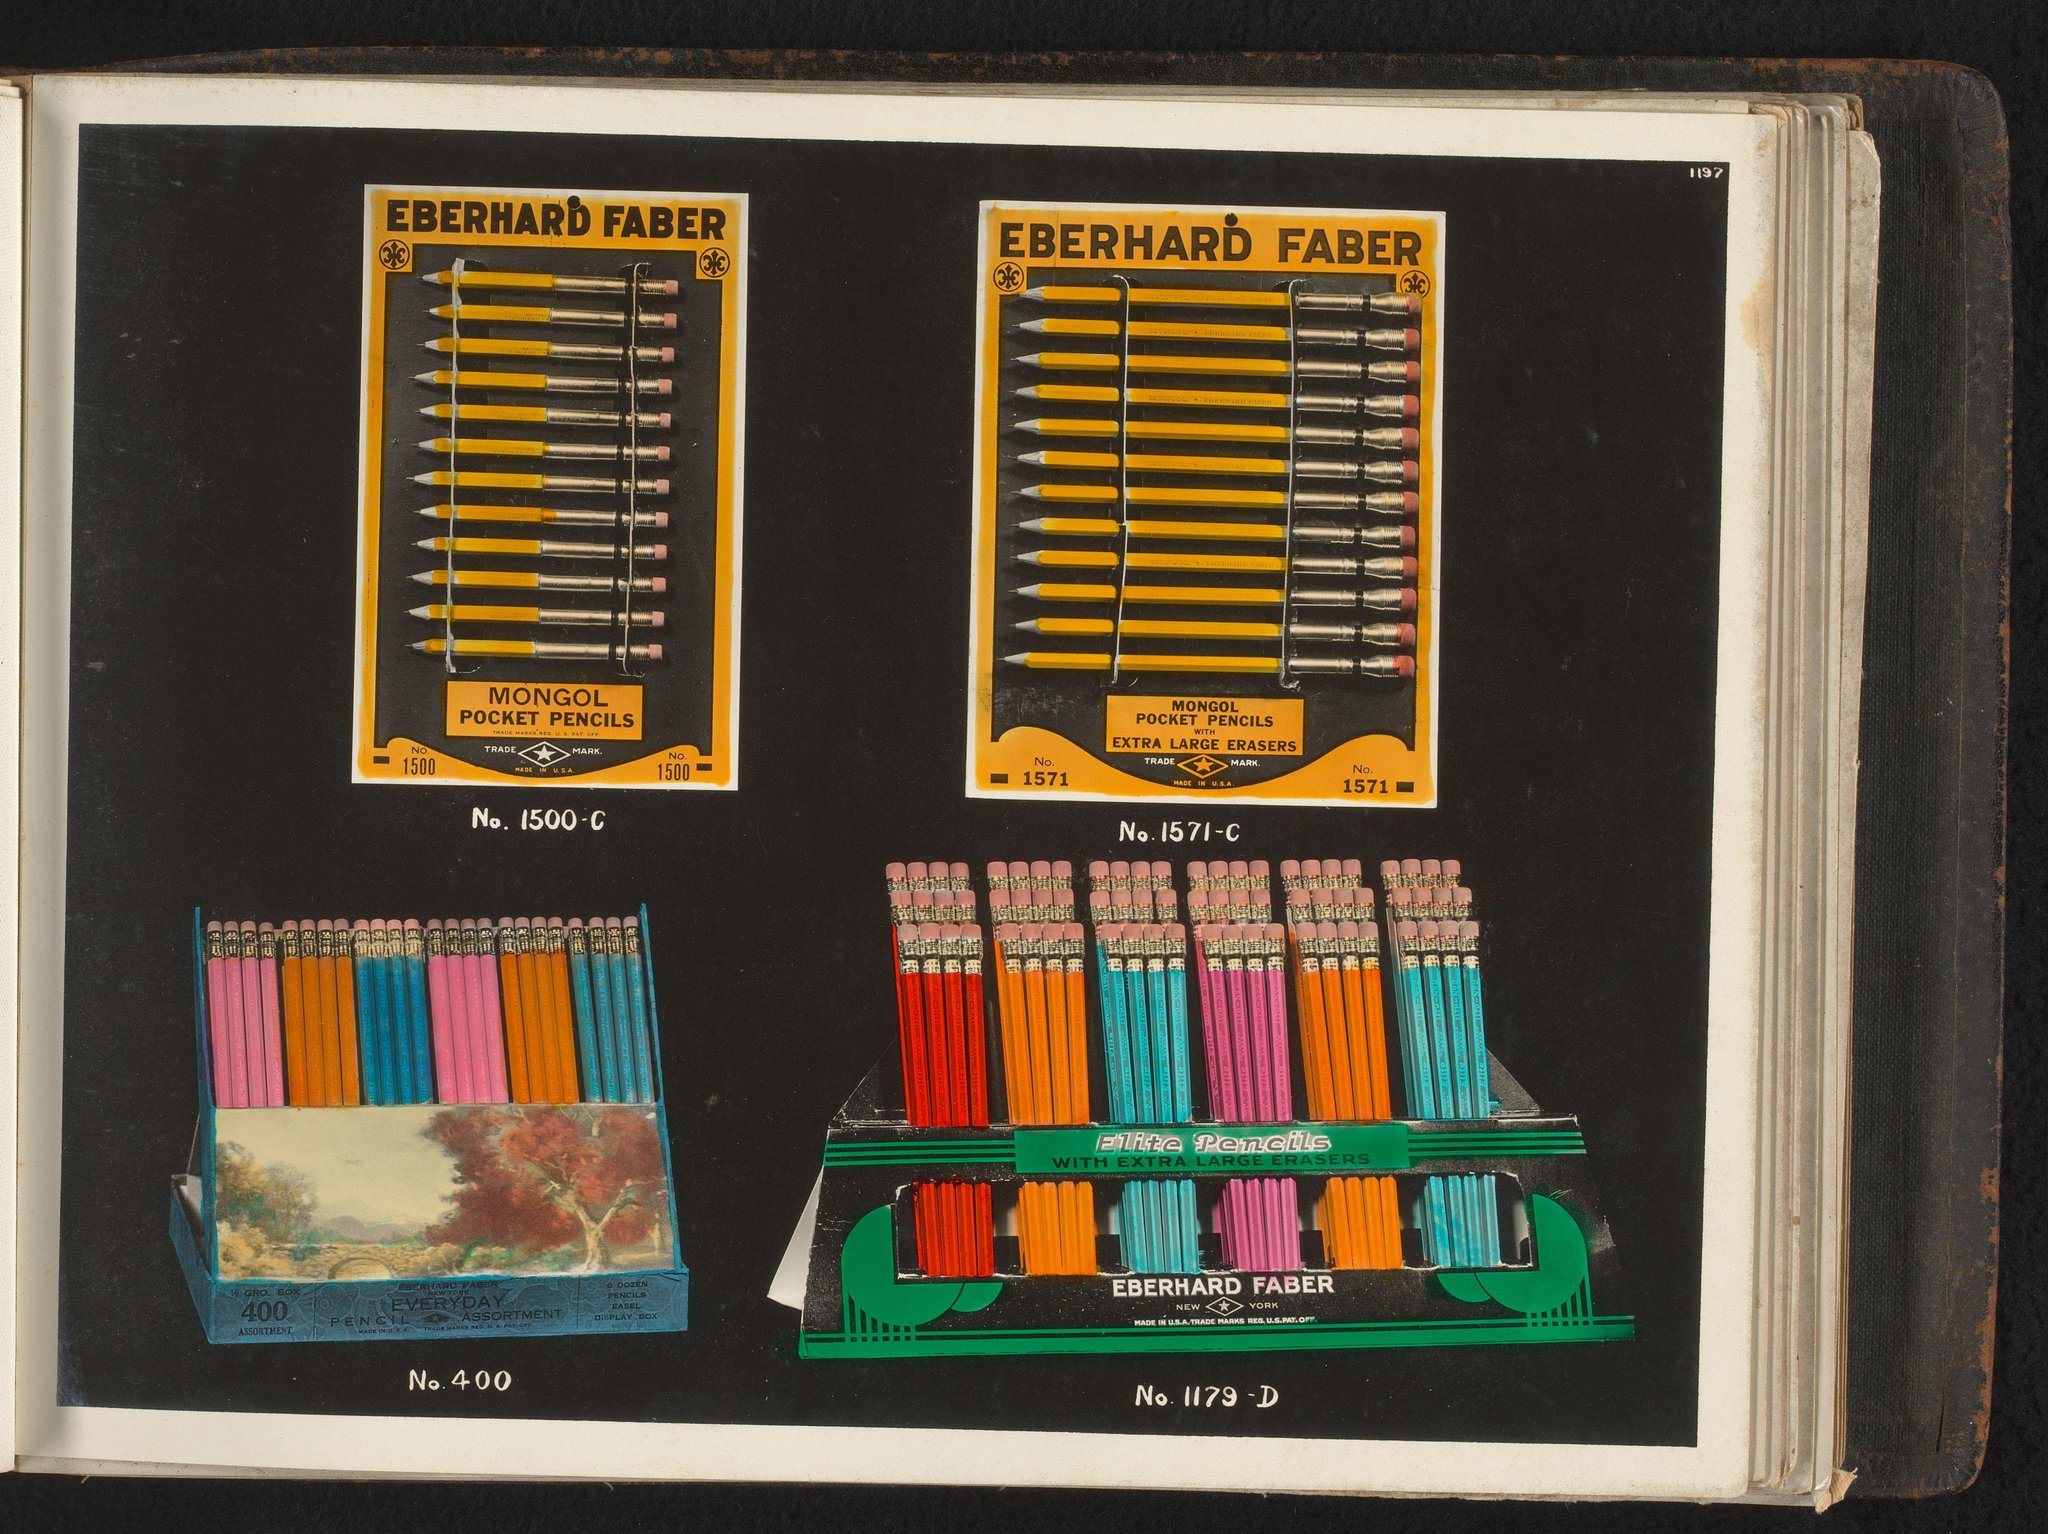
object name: album leaf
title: Sets met potloden van Eberhard Faber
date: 1915-1935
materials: paper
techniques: gelatin silver print, hand coloring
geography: springfield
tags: pencil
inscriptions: number: ‘1197’, stamp: ‘Paramount/ Commercial Studios/ 145 Chestnut St./ Springfield - Mass.’